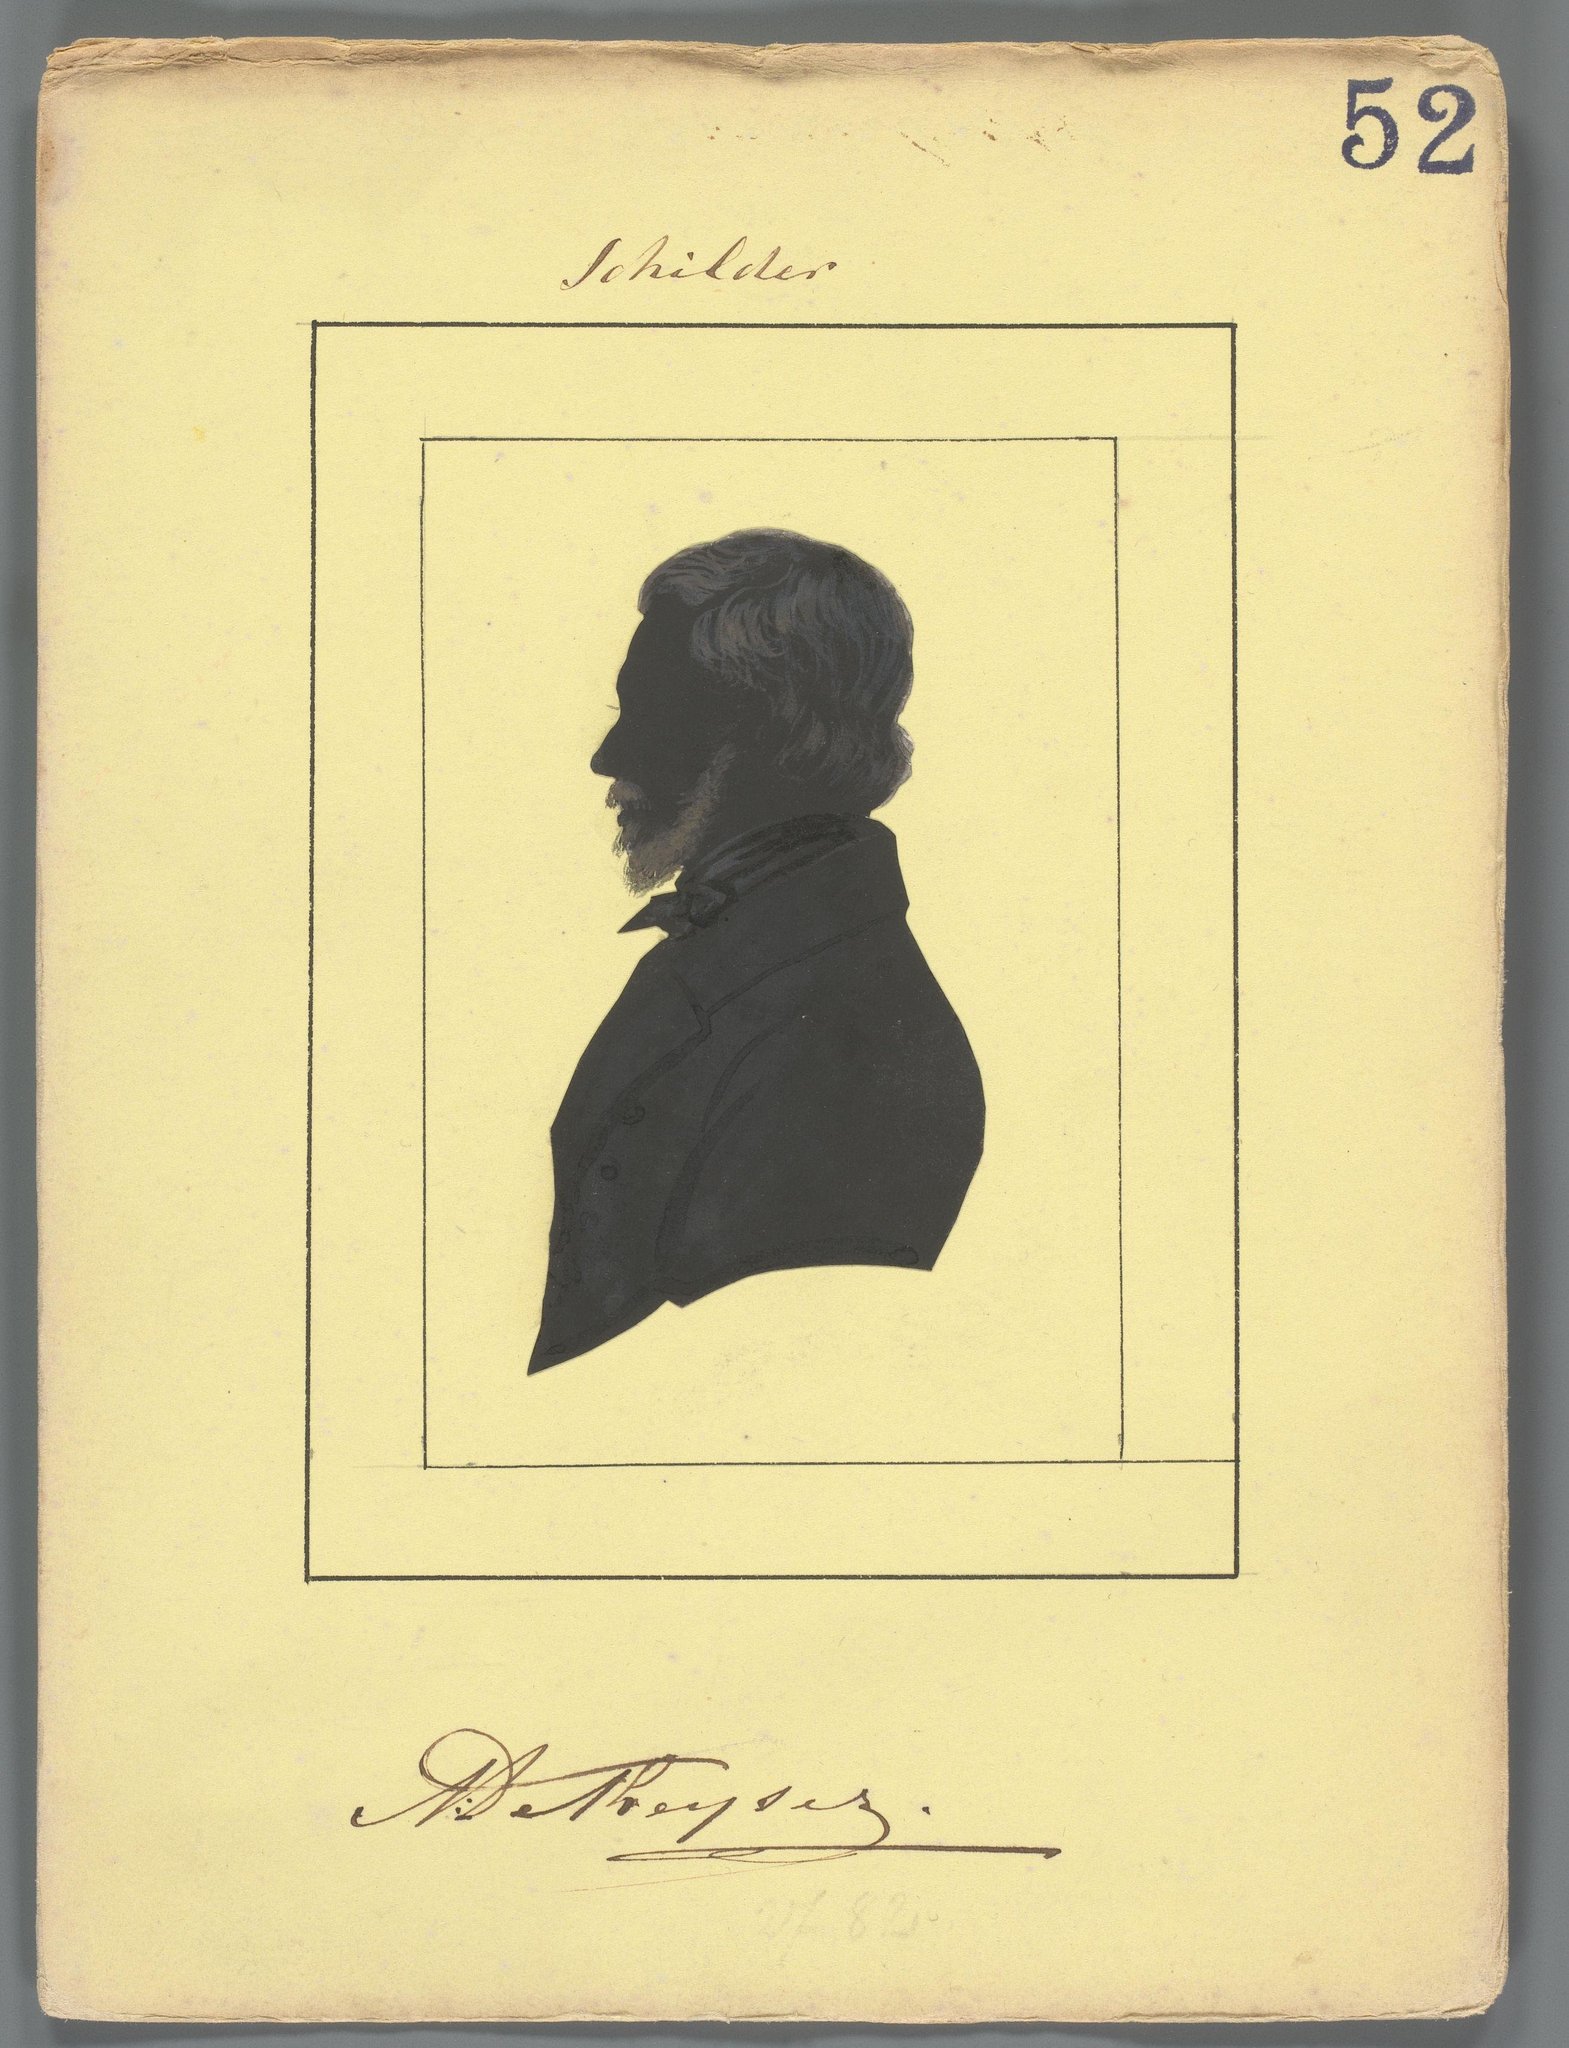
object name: drawing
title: Silhouetportret van Nicaise De Keyser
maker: elisabeth alida haanen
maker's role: draughtsman, print maker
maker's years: 1809-1845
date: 1819-1845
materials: ink, paint, paper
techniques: brush, snipping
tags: antwerp, painter, nicaise de keyser, historical persons, portrait, self-portrait of painter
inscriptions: collector's mark: ‘Ex-libris van Beresteyn’, number: ‘52’, number: ‘13977’, inscription: ‘N: De Keyser’, inscription: ‘Neg. D. 1777’, inscription: ‘Schilder’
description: Met onder het portret de handtekening van de geportretteerde.